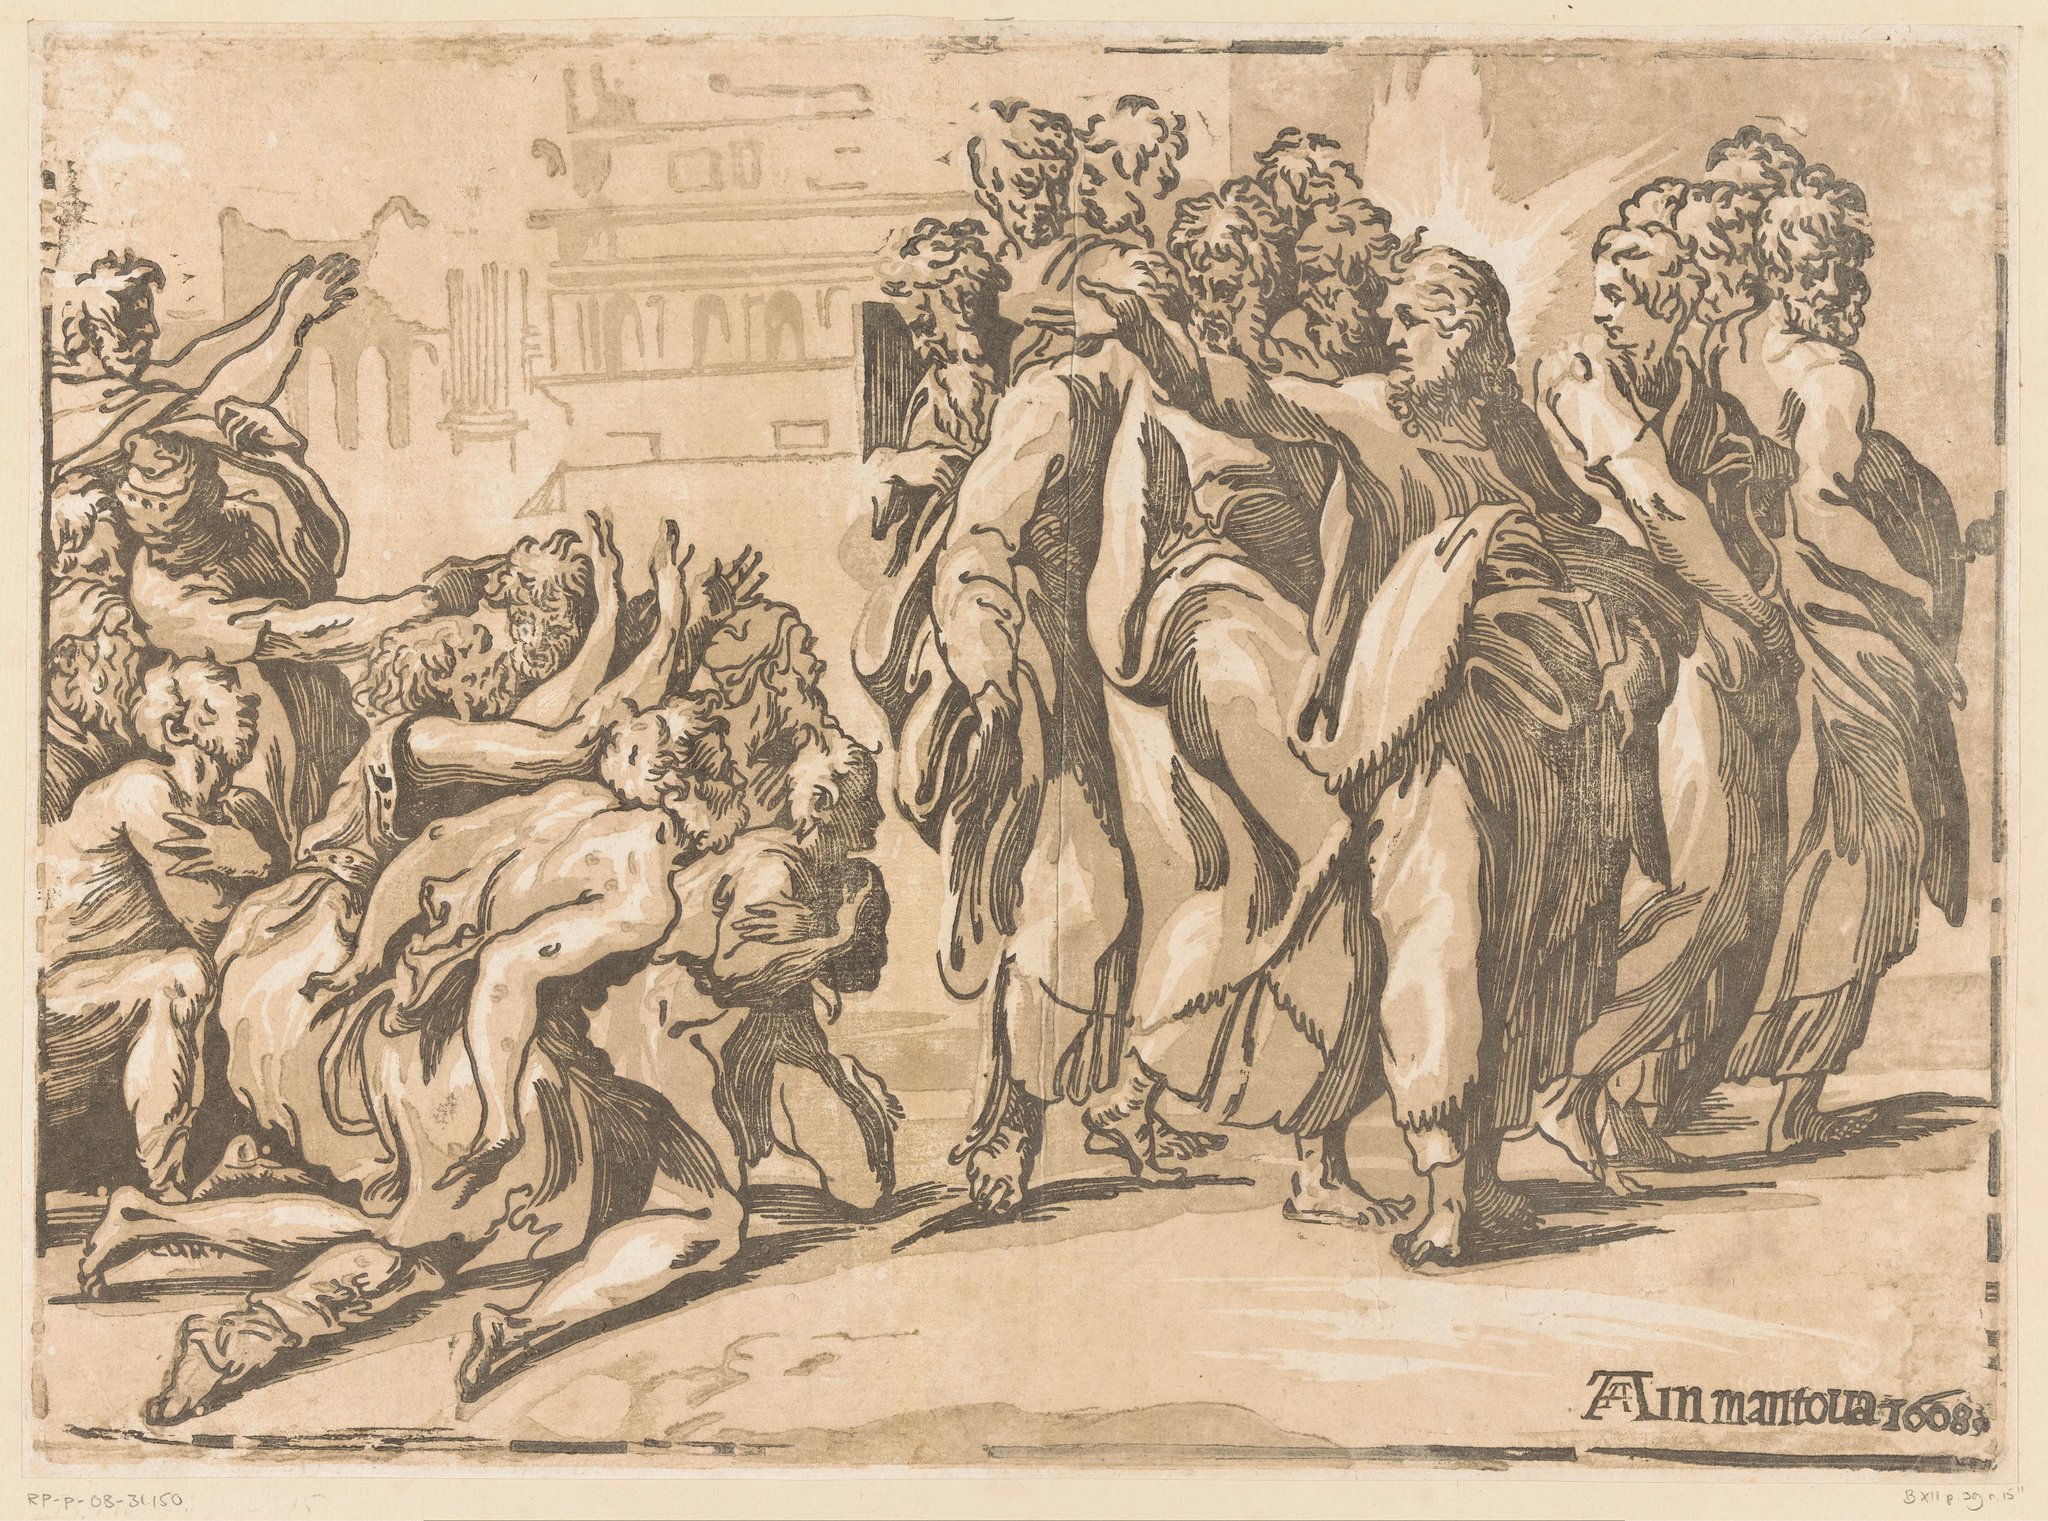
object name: print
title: Christus geneest melaatsen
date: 1608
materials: paper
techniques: woodcut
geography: mantua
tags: christ healing lepers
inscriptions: collector's mark: Lugt 240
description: Christus met de apostelen en een groep smekende melaatsen.